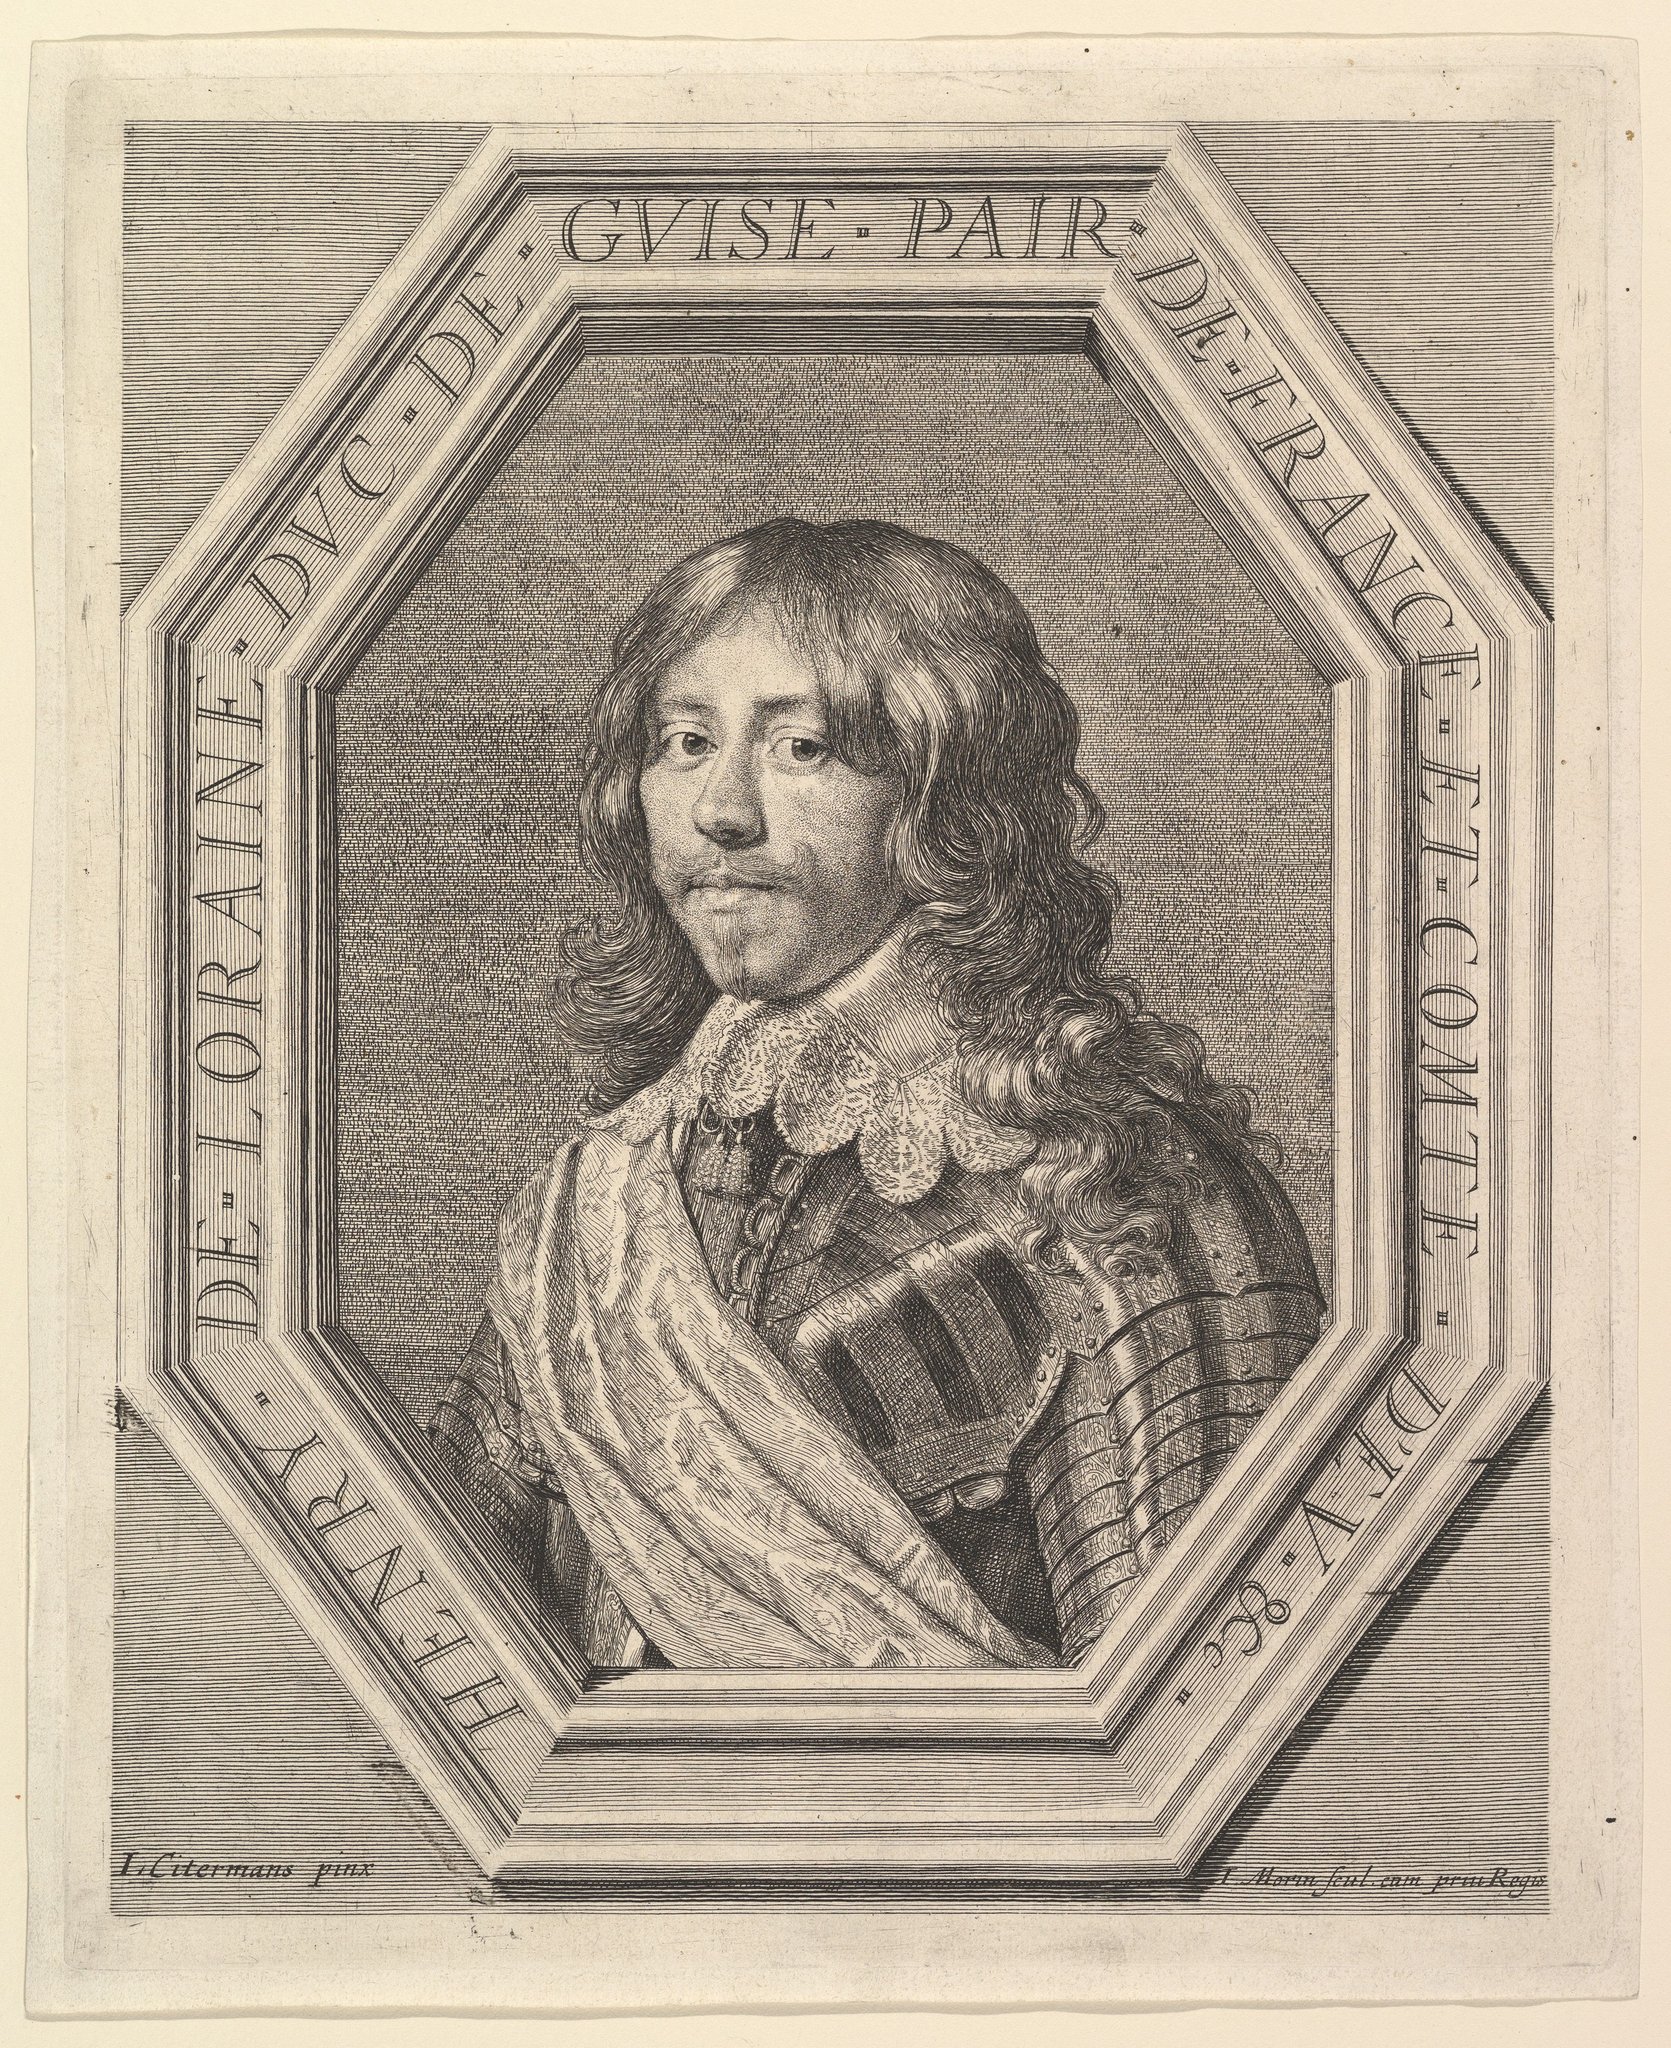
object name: print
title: Henri II de Lorraine, duc de Guise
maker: jean morin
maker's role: artist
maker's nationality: french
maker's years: 1605-1650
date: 1605-1650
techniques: etching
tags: men,portraits